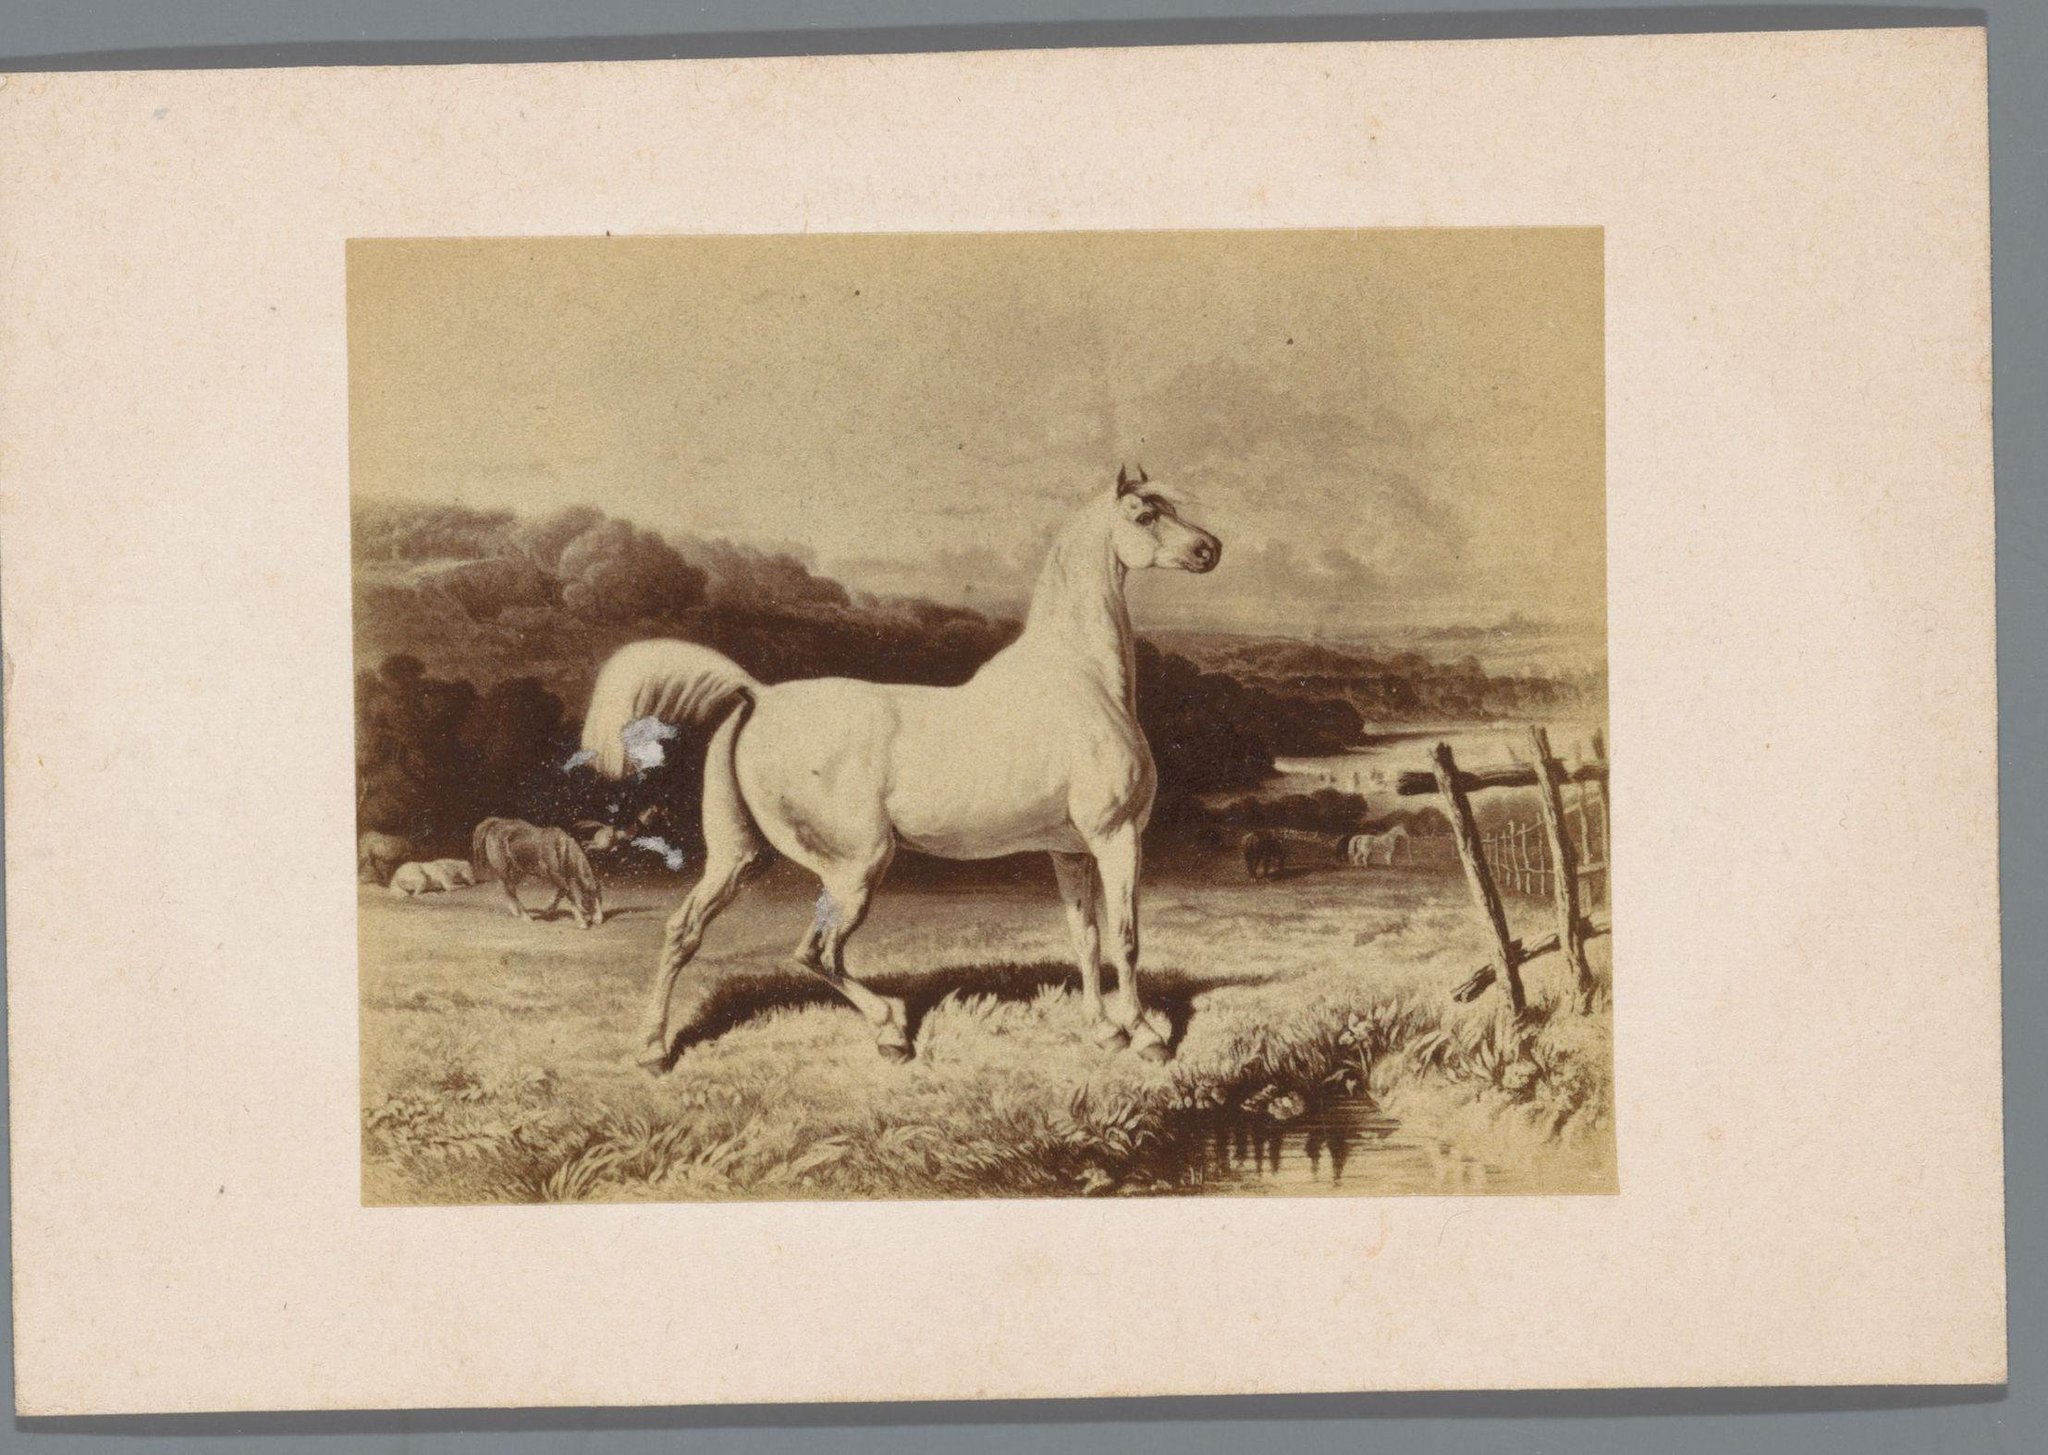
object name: carte de visite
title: Fotoreproductie van een schilderij naar het gedicht Het paard door J.J.L. ten Kate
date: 1850-1900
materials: cardboard, photographic support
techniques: albumen print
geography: amsterdam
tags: horse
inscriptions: inscription: ‘HET PAARD./ (VAN JOB.)/ (...) sterven gewijd!/ J. J. L. TEN KATE.’